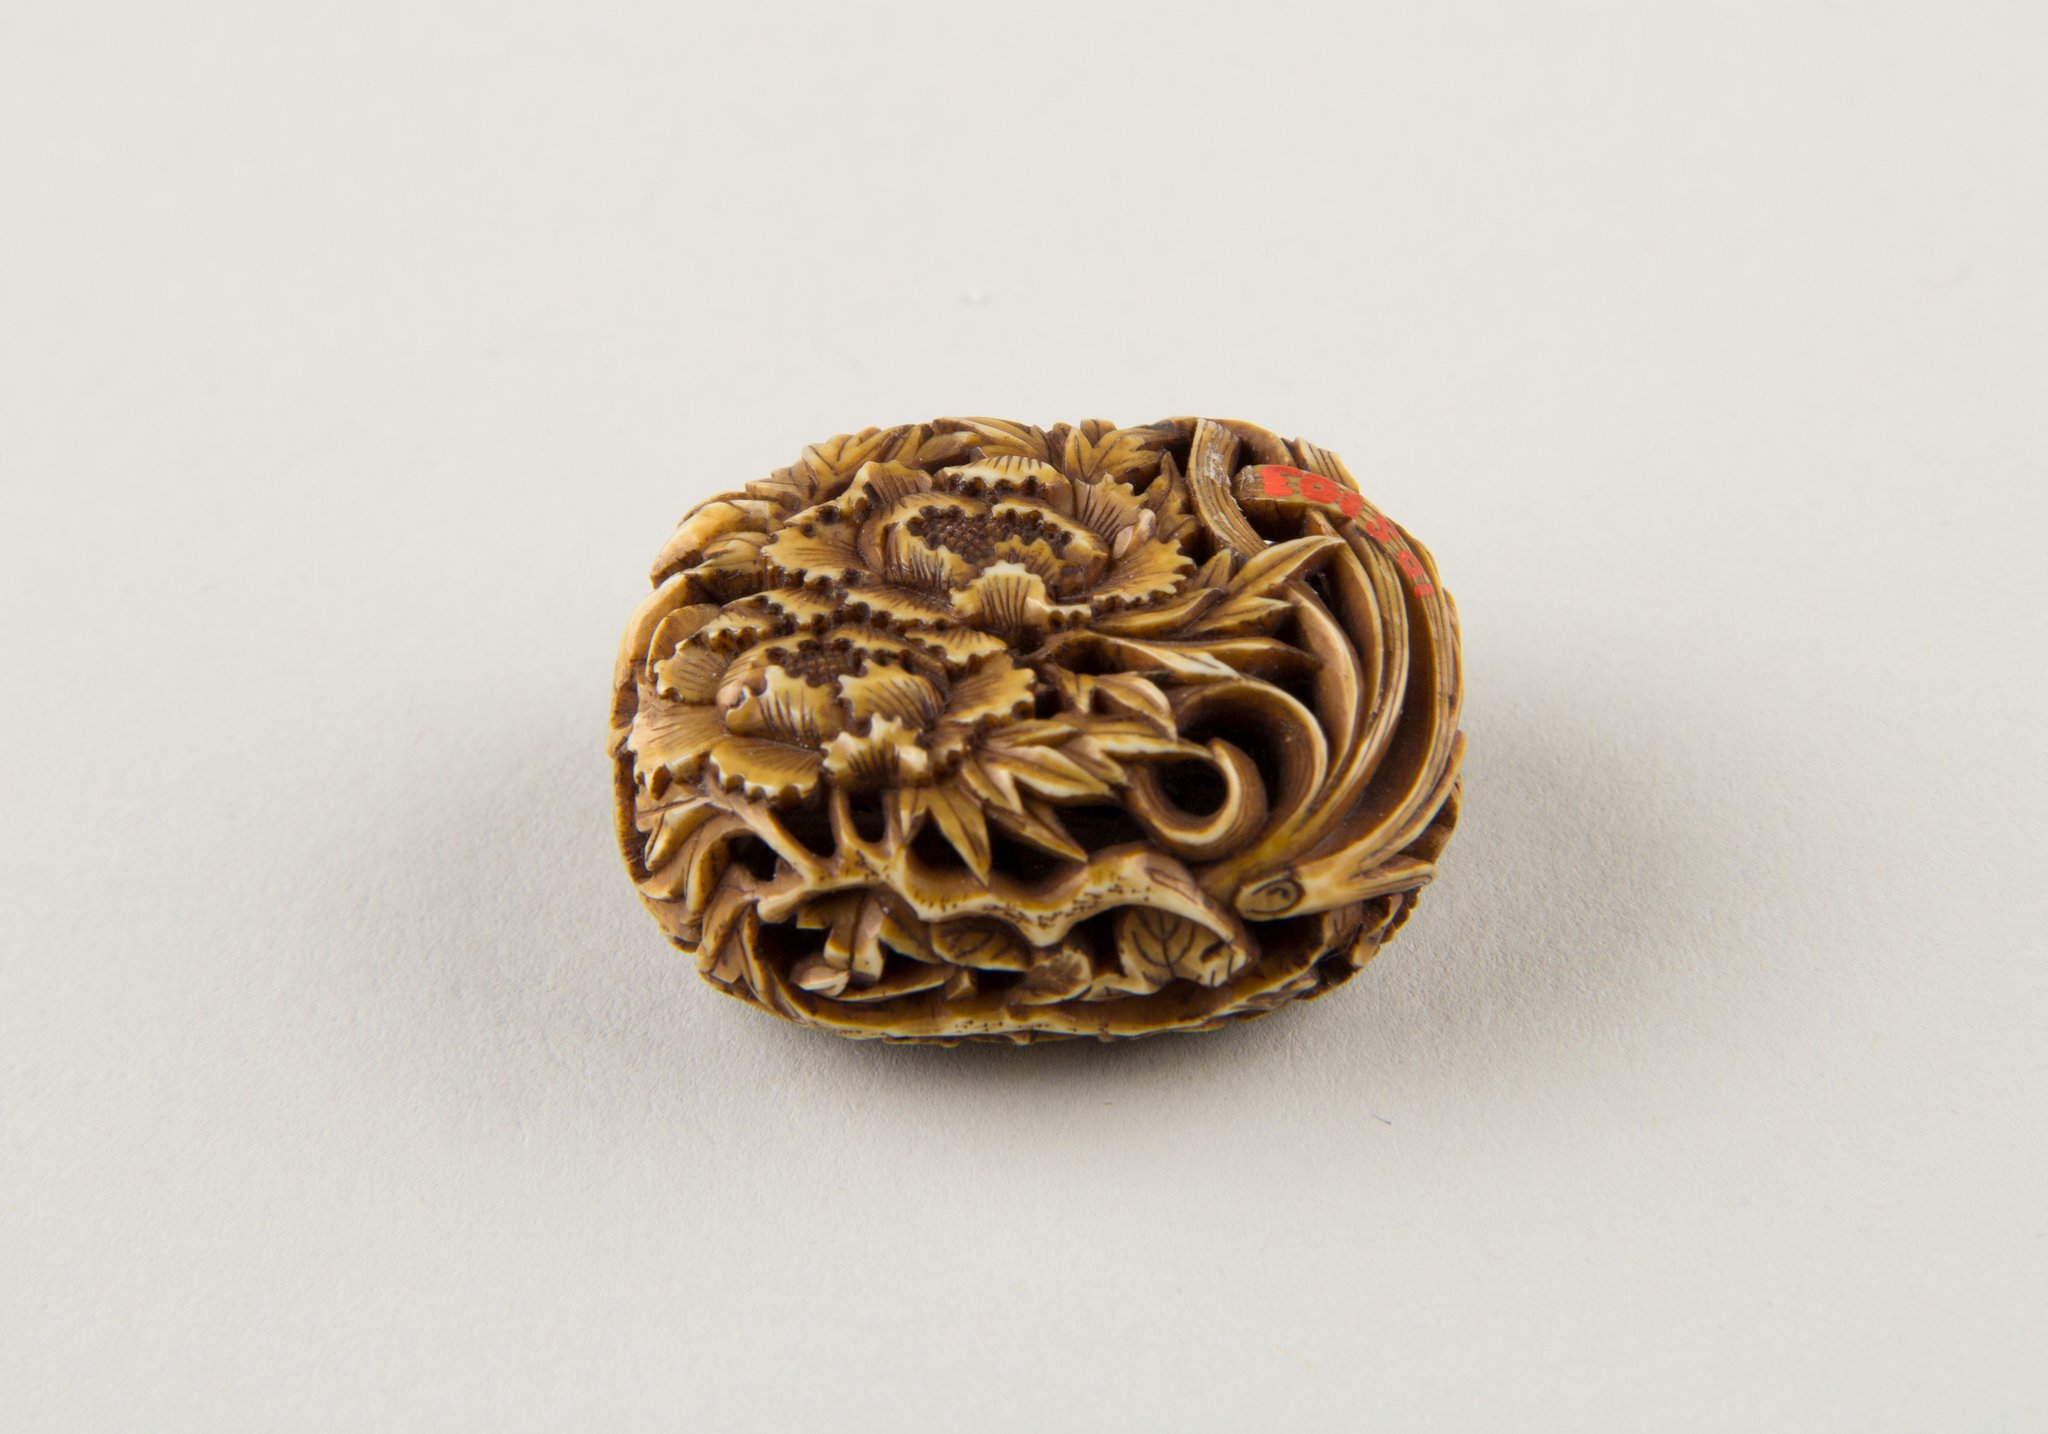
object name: netsuke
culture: japanese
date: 1801-1900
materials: ivory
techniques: carving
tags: flowers